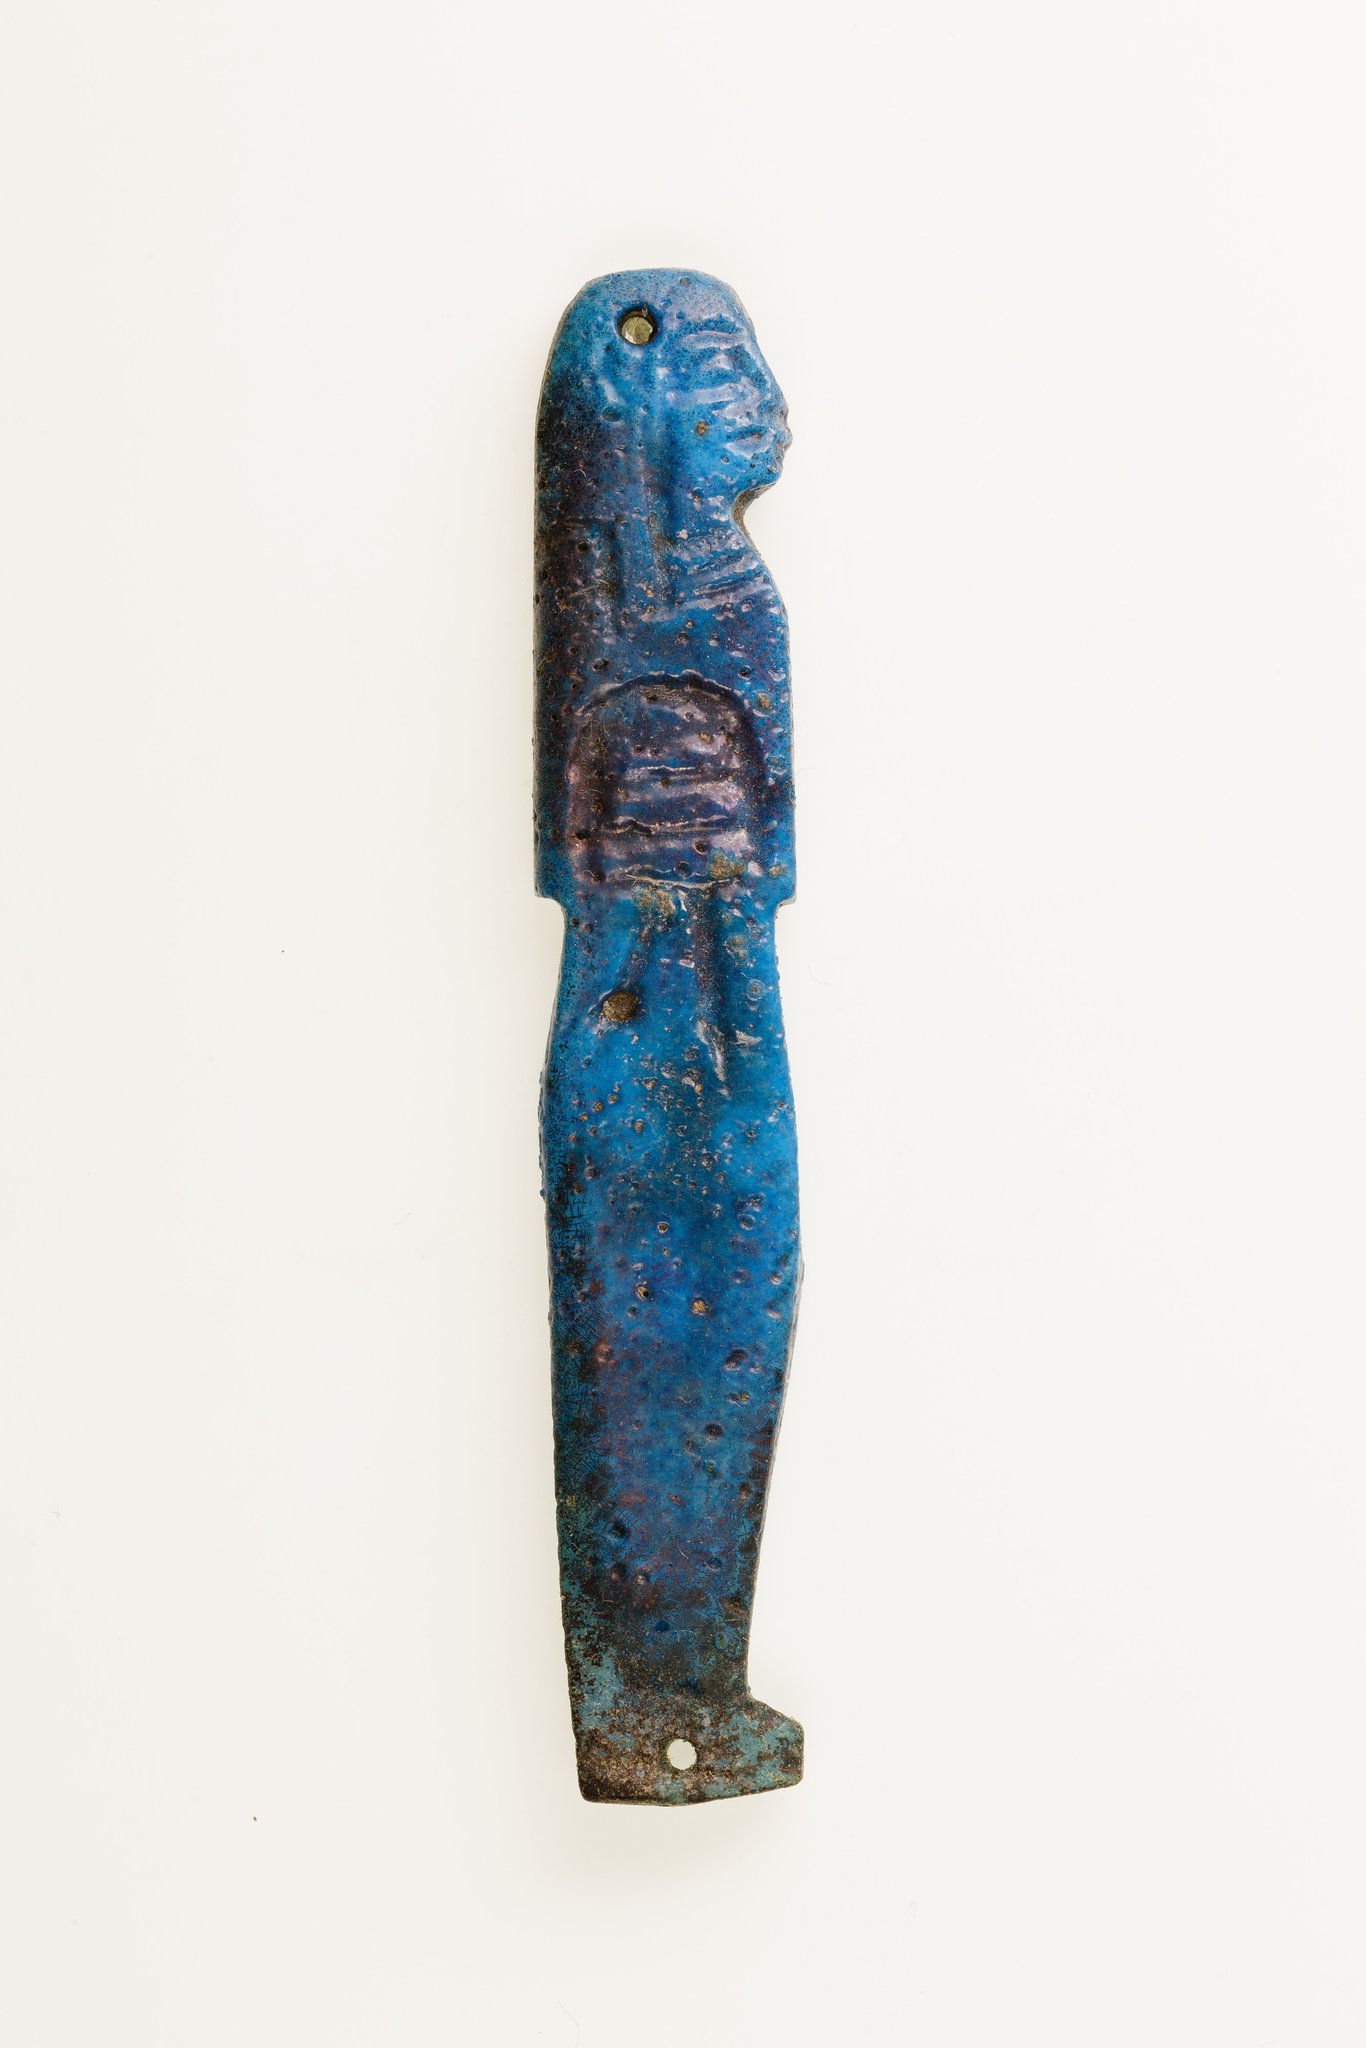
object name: amulet, son of horus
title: Son of Horus (Imseti) from Bead Net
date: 1070-525 BCE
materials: faience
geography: egypt